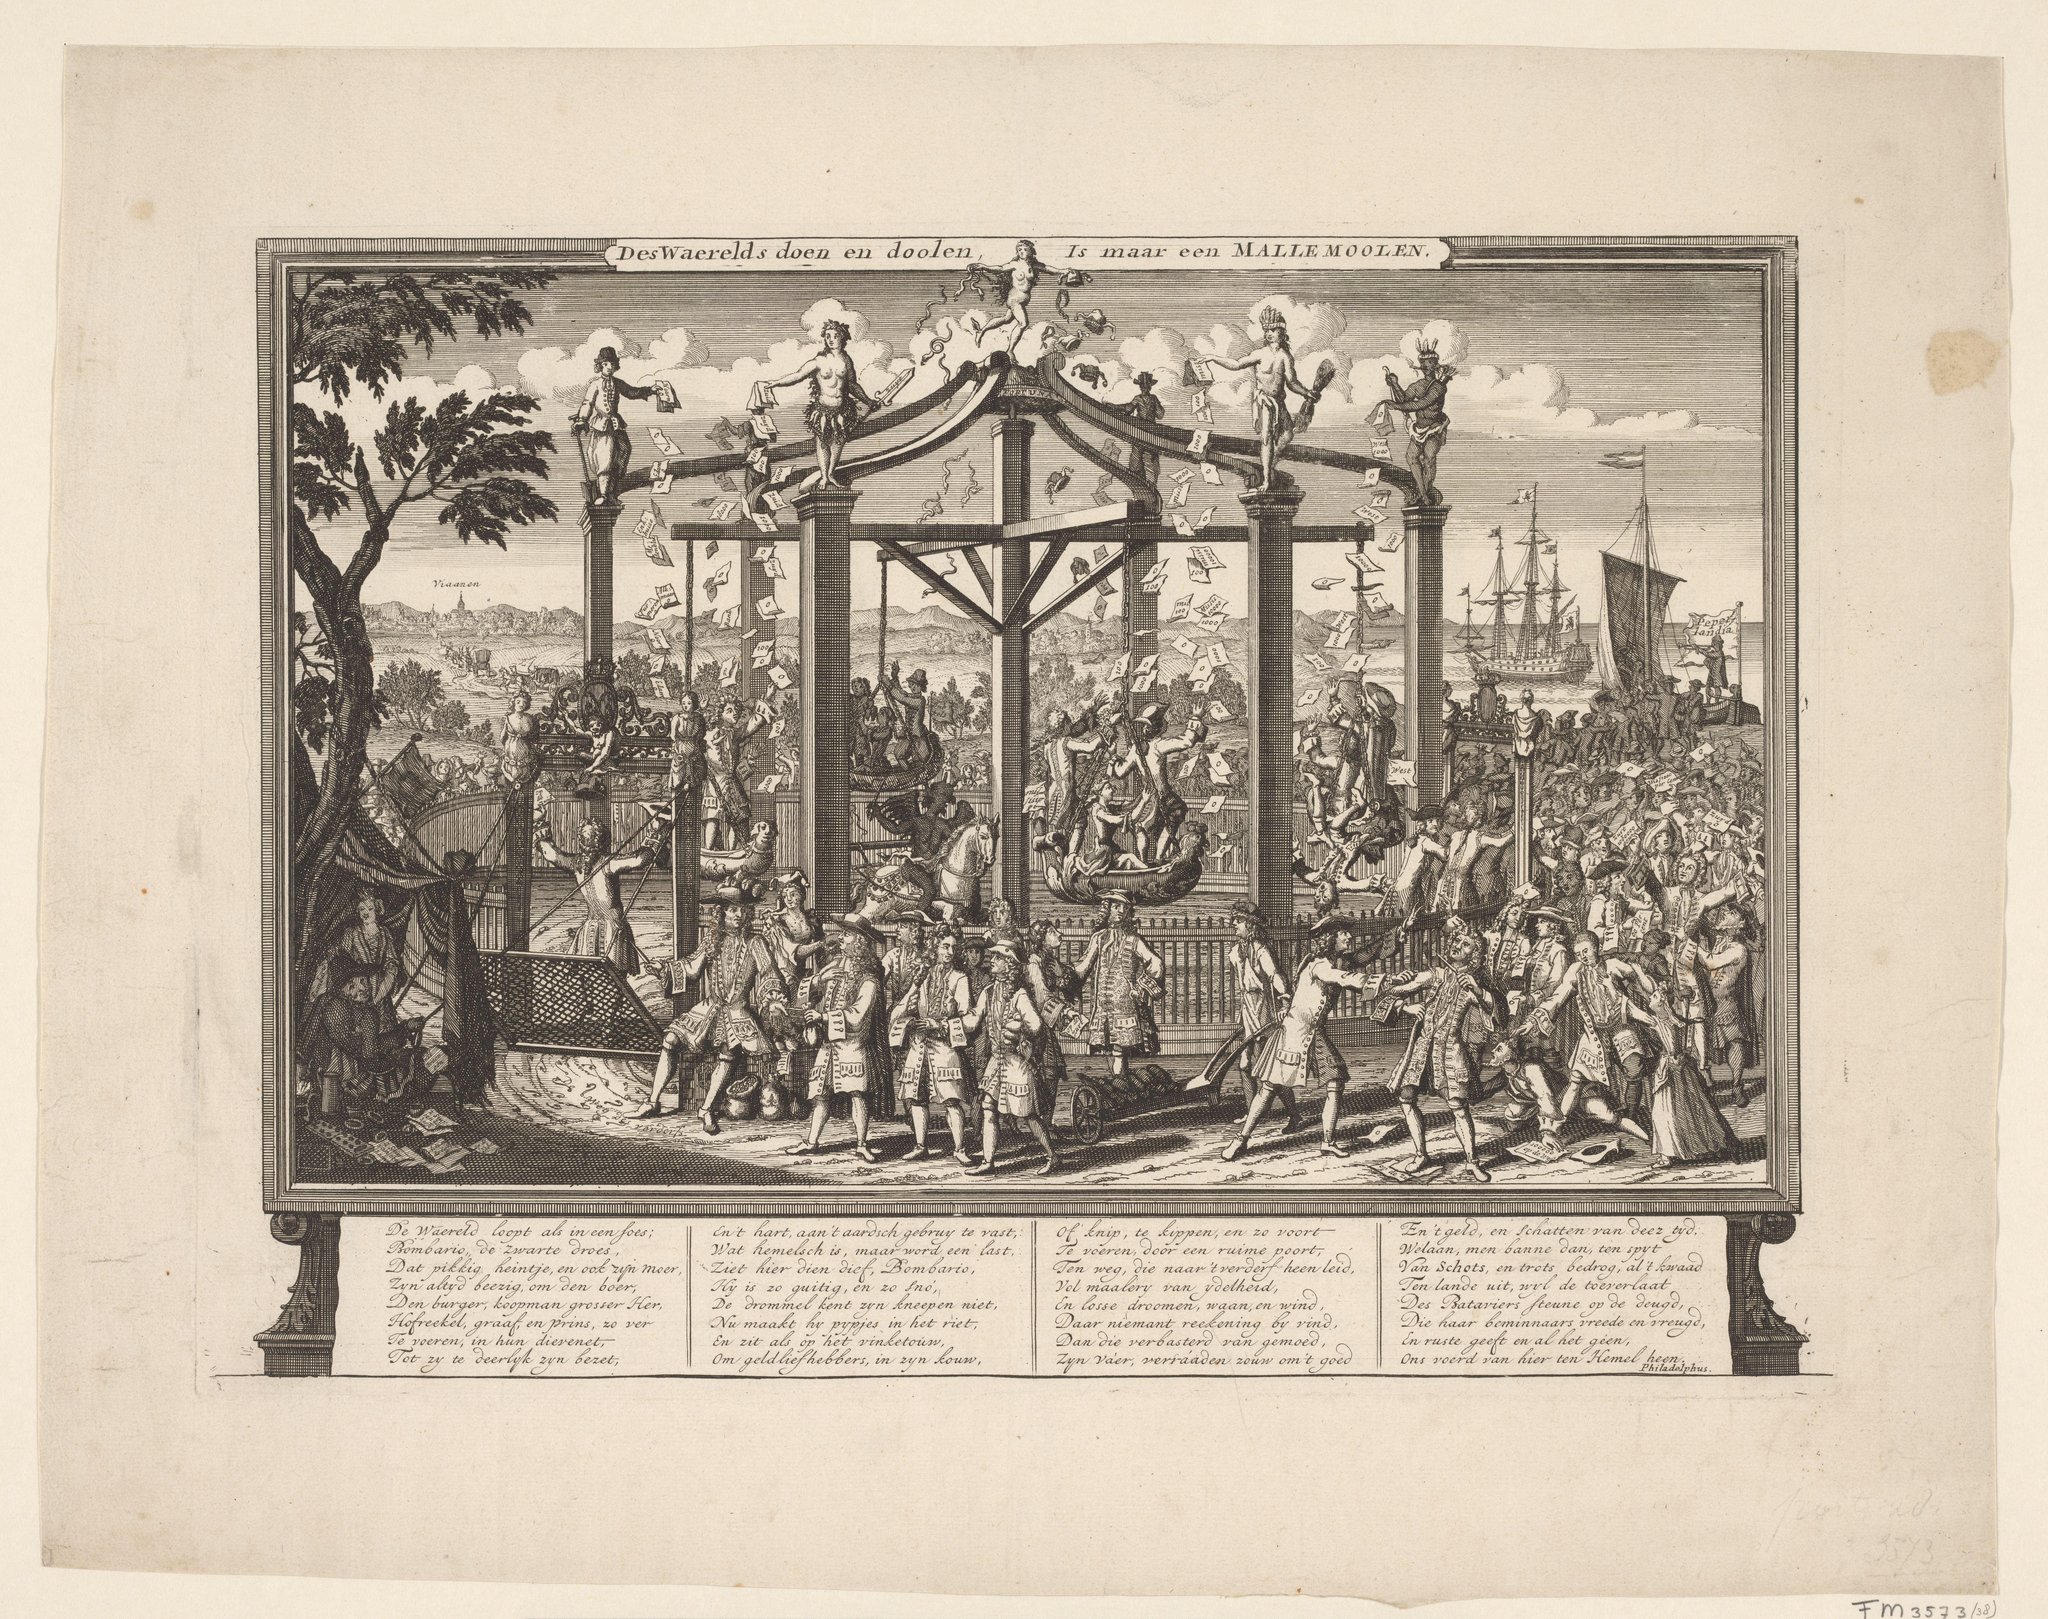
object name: print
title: Het Groote Tafereel der Dwaasheid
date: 1720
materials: paper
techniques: etching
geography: northern netherlands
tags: merry-go-round, roundabout; chair o'plane, financial panic, indigenous peoples of the caribbean, indigenous peoples of north america, indigenous peoples of south america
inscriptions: collector's mark: Lugt 2228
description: De Mallemolen van de Wereld. Een draaimolen waarin de windhandelaren staande in de bakjes pogingen doen om aandelenbriefjes te bemachtigen die door figuren (een boer, en oorspronkelijke bewoners van de Zuidzee, Mississippi en West-Indië) staande op de stijlen van de molen worden gestrooid. Op de voorgrond wachten andere heren op hun rit in de mallemolen, rechts wanhopige actionisten. Op de achtergrond links Vianen, rechts schepen op zee. Met onderschrift in vier kolommen door Philadelphus. Prent 38 in de serie Het Groote Tafereel der Dwaasheid met spotprenten op de Windhandel of Actiehandel van 1720.